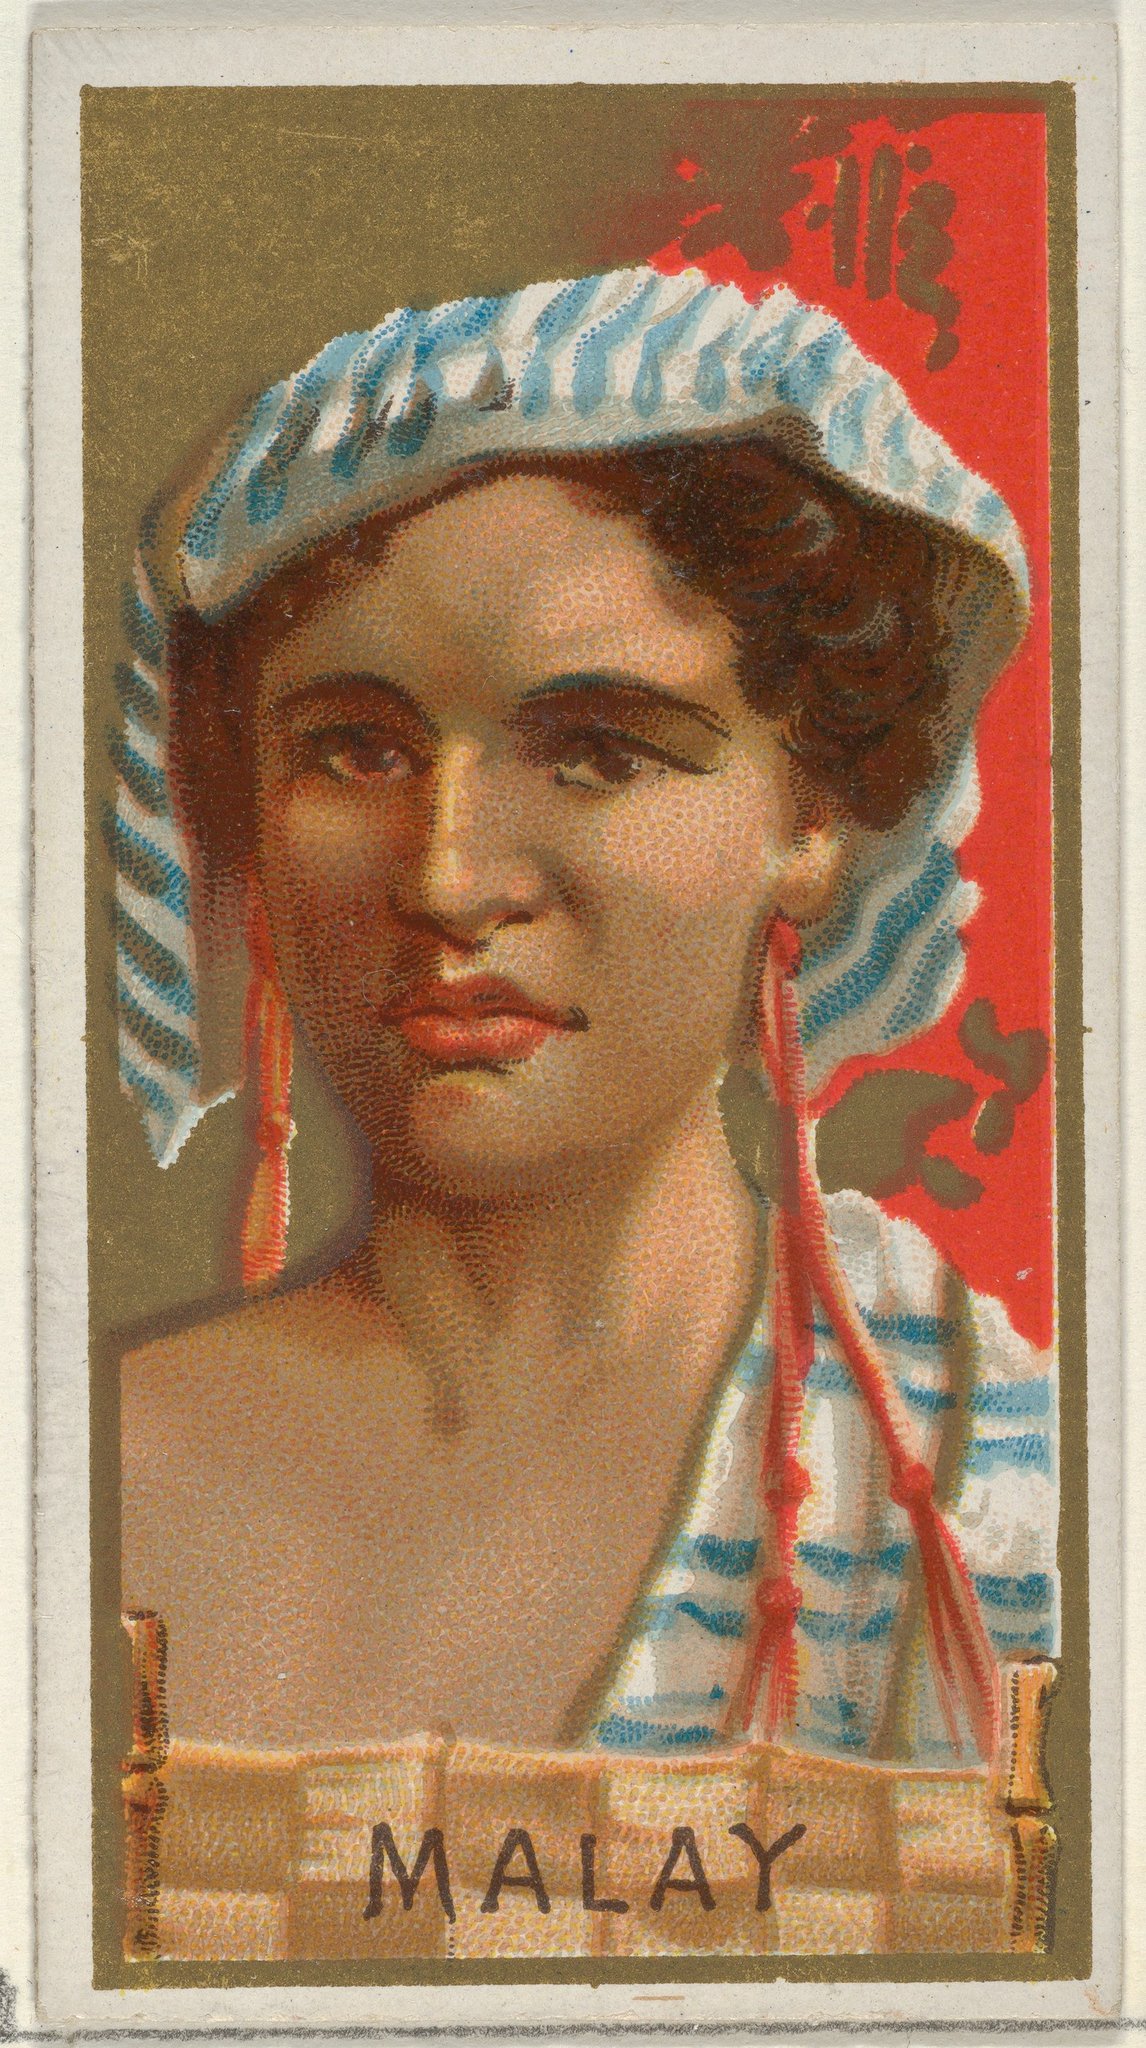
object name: print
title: Malay, from the Types of All Nations series (N24) for Allen & Ginter Cigarettes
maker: allen & ginter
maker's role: publisher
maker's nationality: american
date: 1889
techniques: color lithograph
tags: women